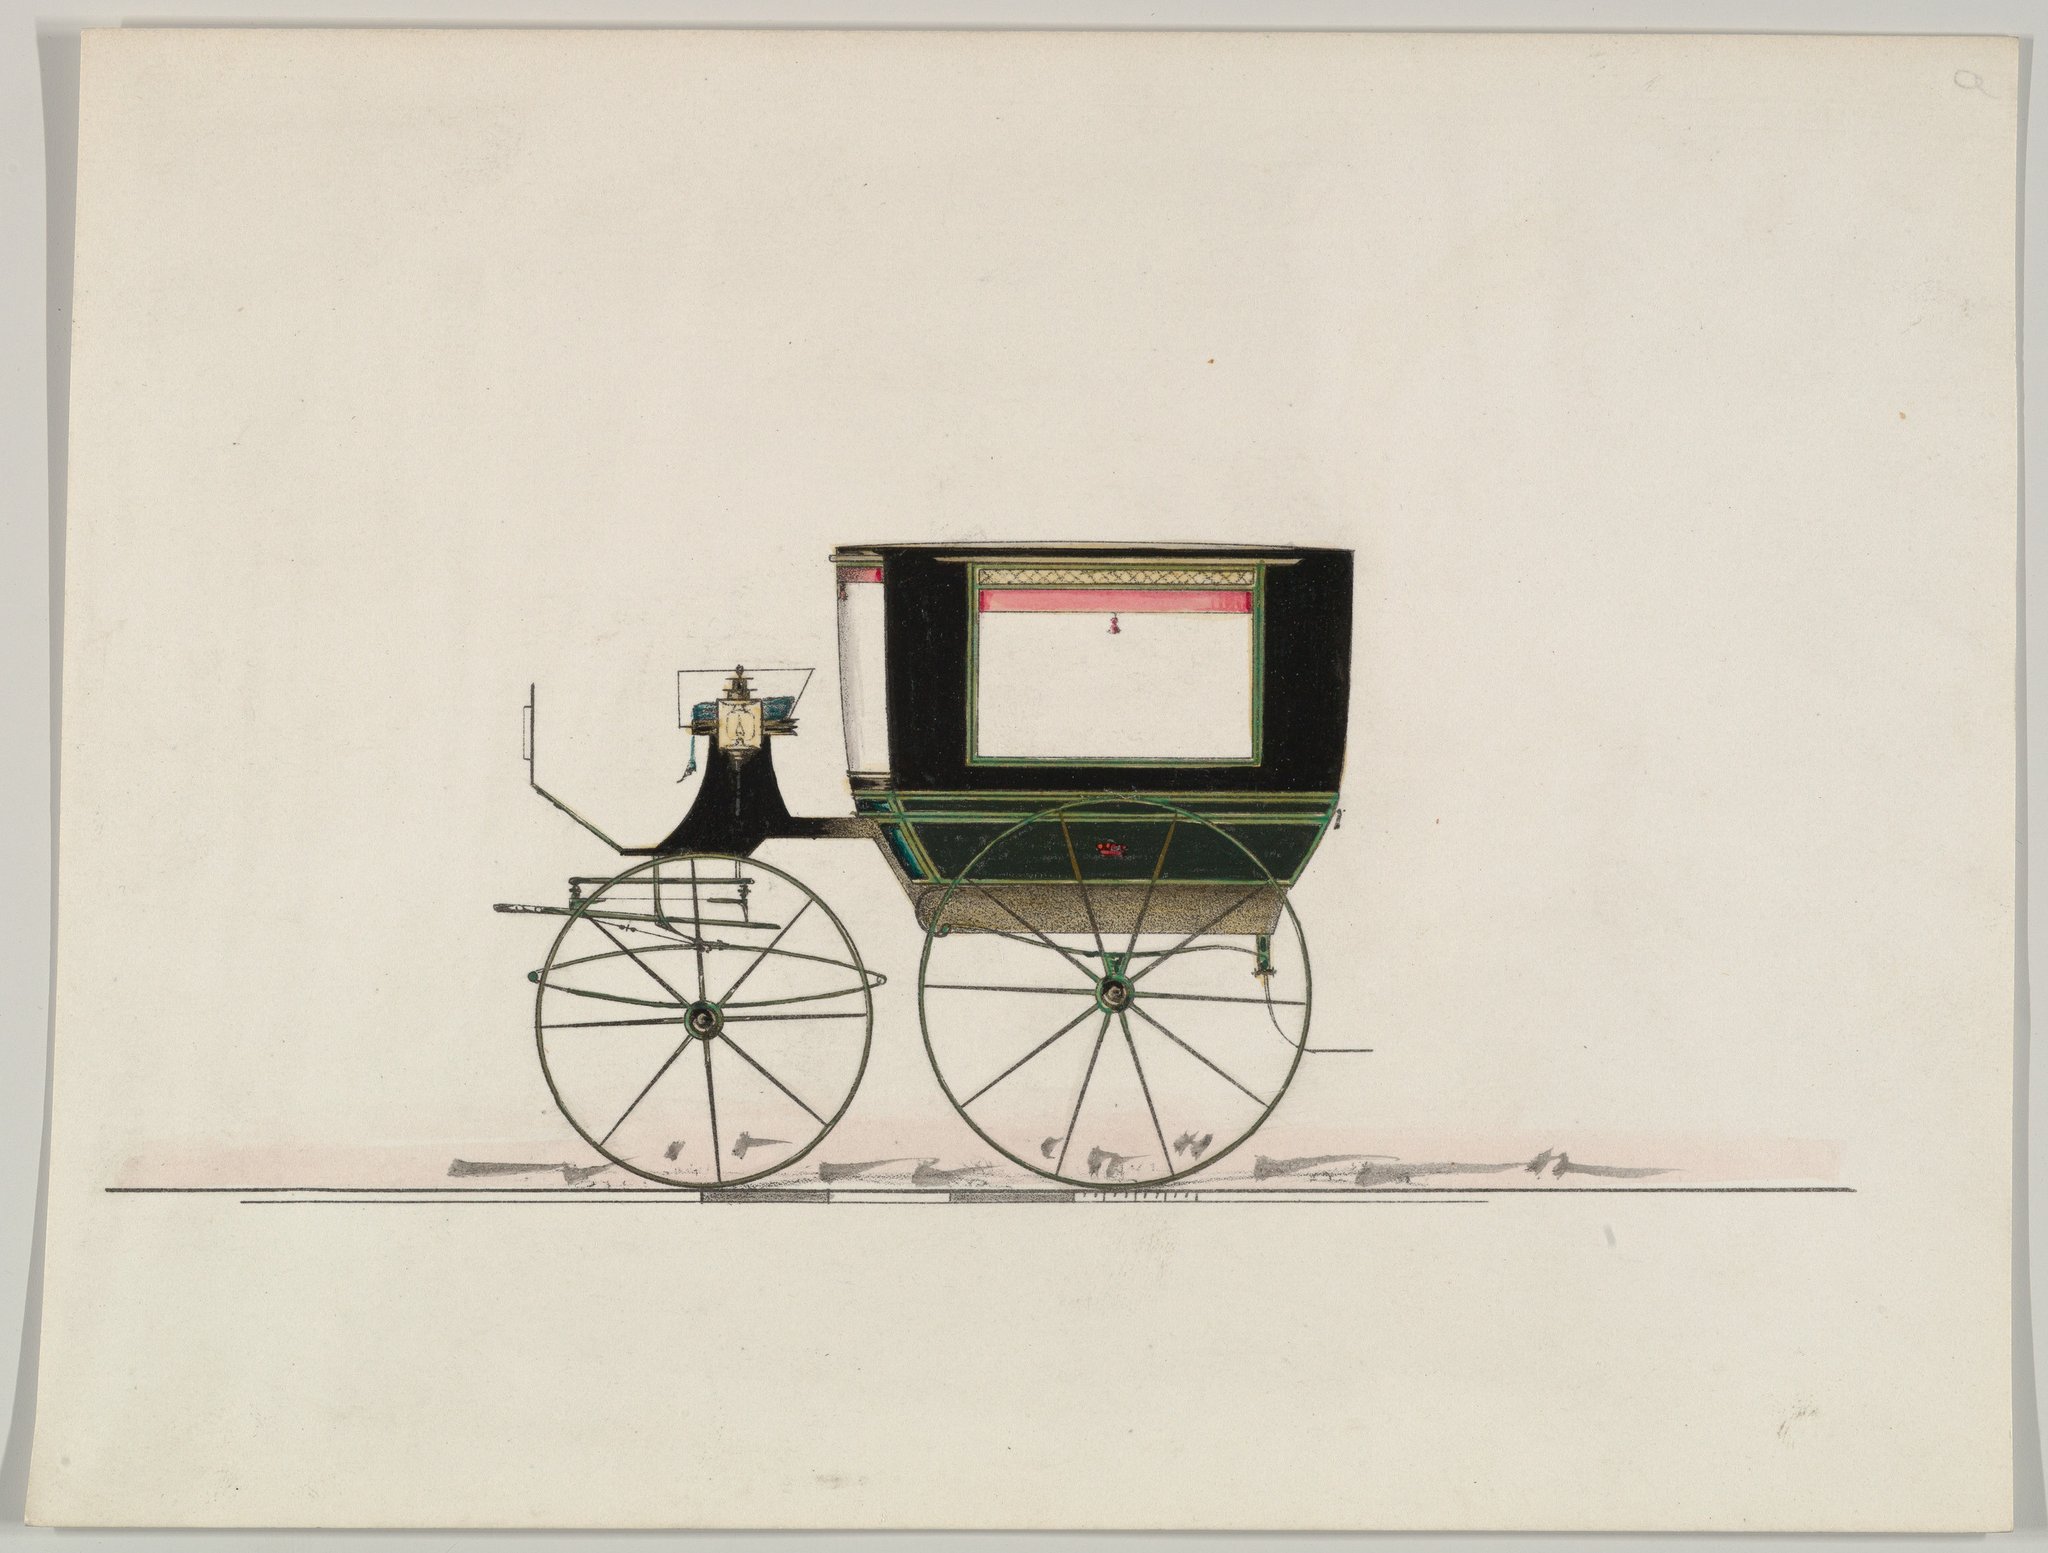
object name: drawing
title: Wagonette Omnibus (unnumbered)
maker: brewster & co.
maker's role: manufacturer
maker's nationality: american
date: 1850-1870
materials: gouache, gum arabic, ink, watercolor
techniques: pen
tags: carriages